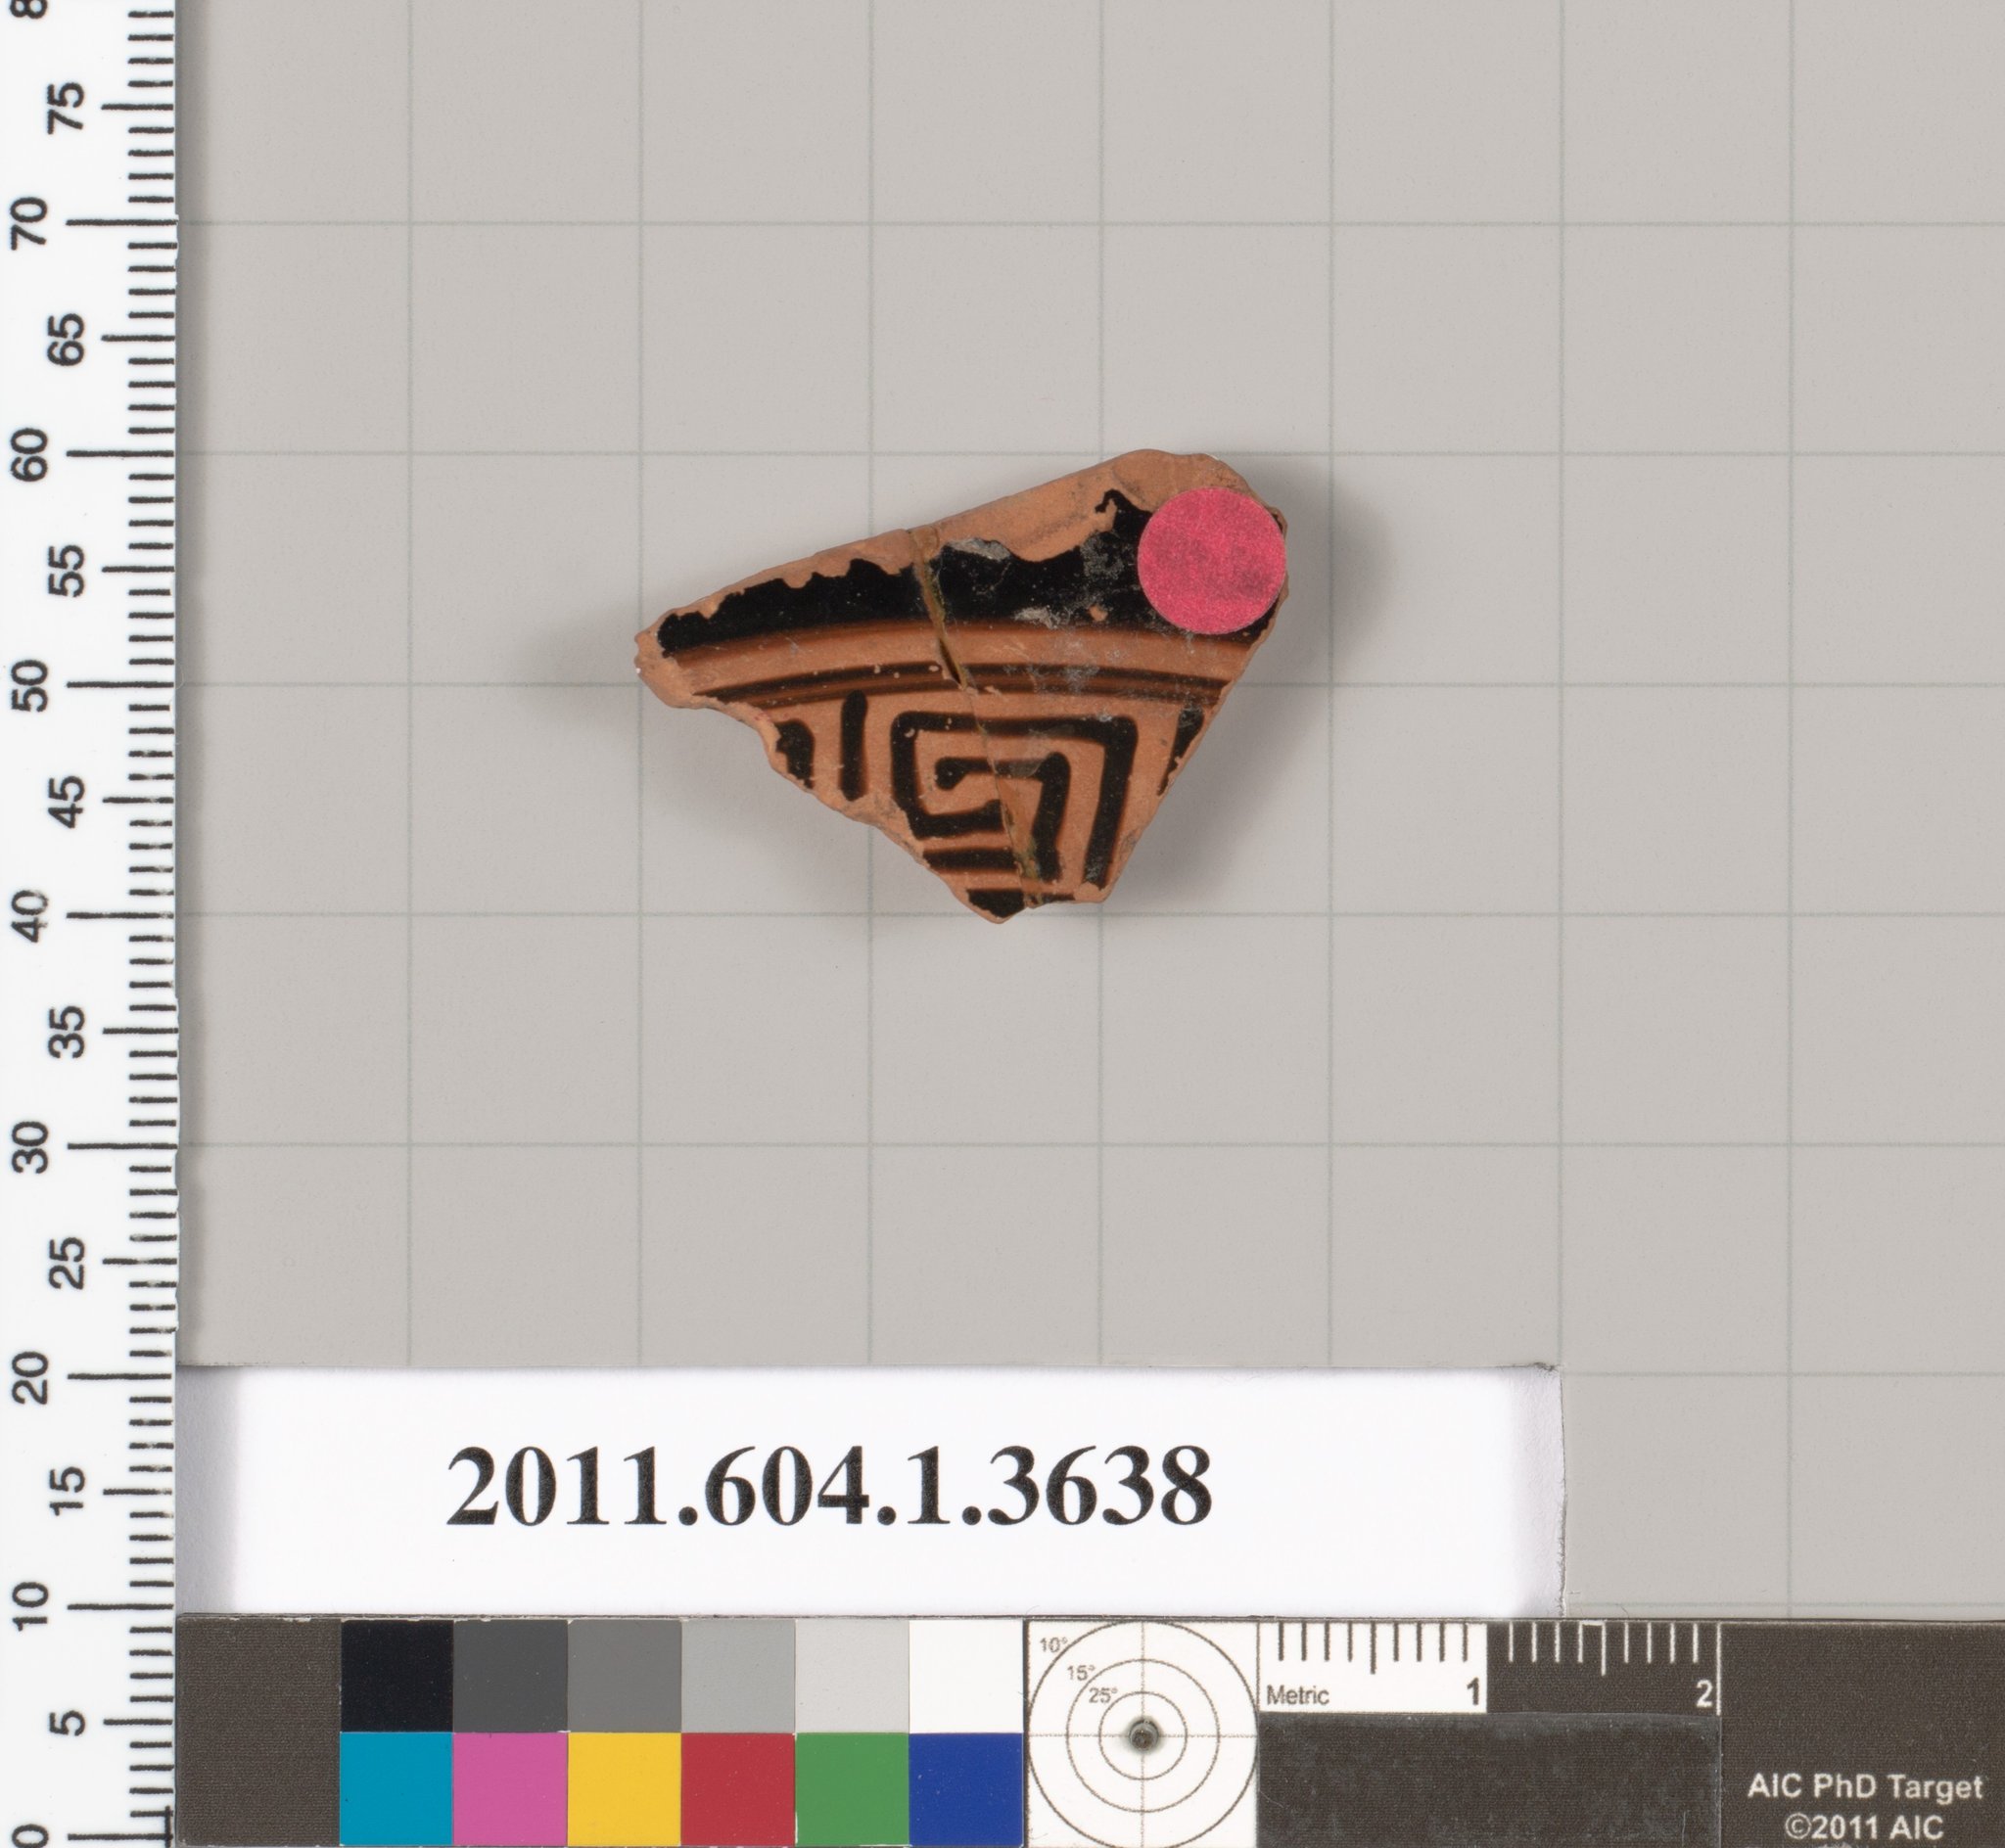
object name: kylix fragment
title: Terracotta fragment of a kylix (drinking cup)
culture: greek, attic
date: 475-451 BCE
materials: terracotta